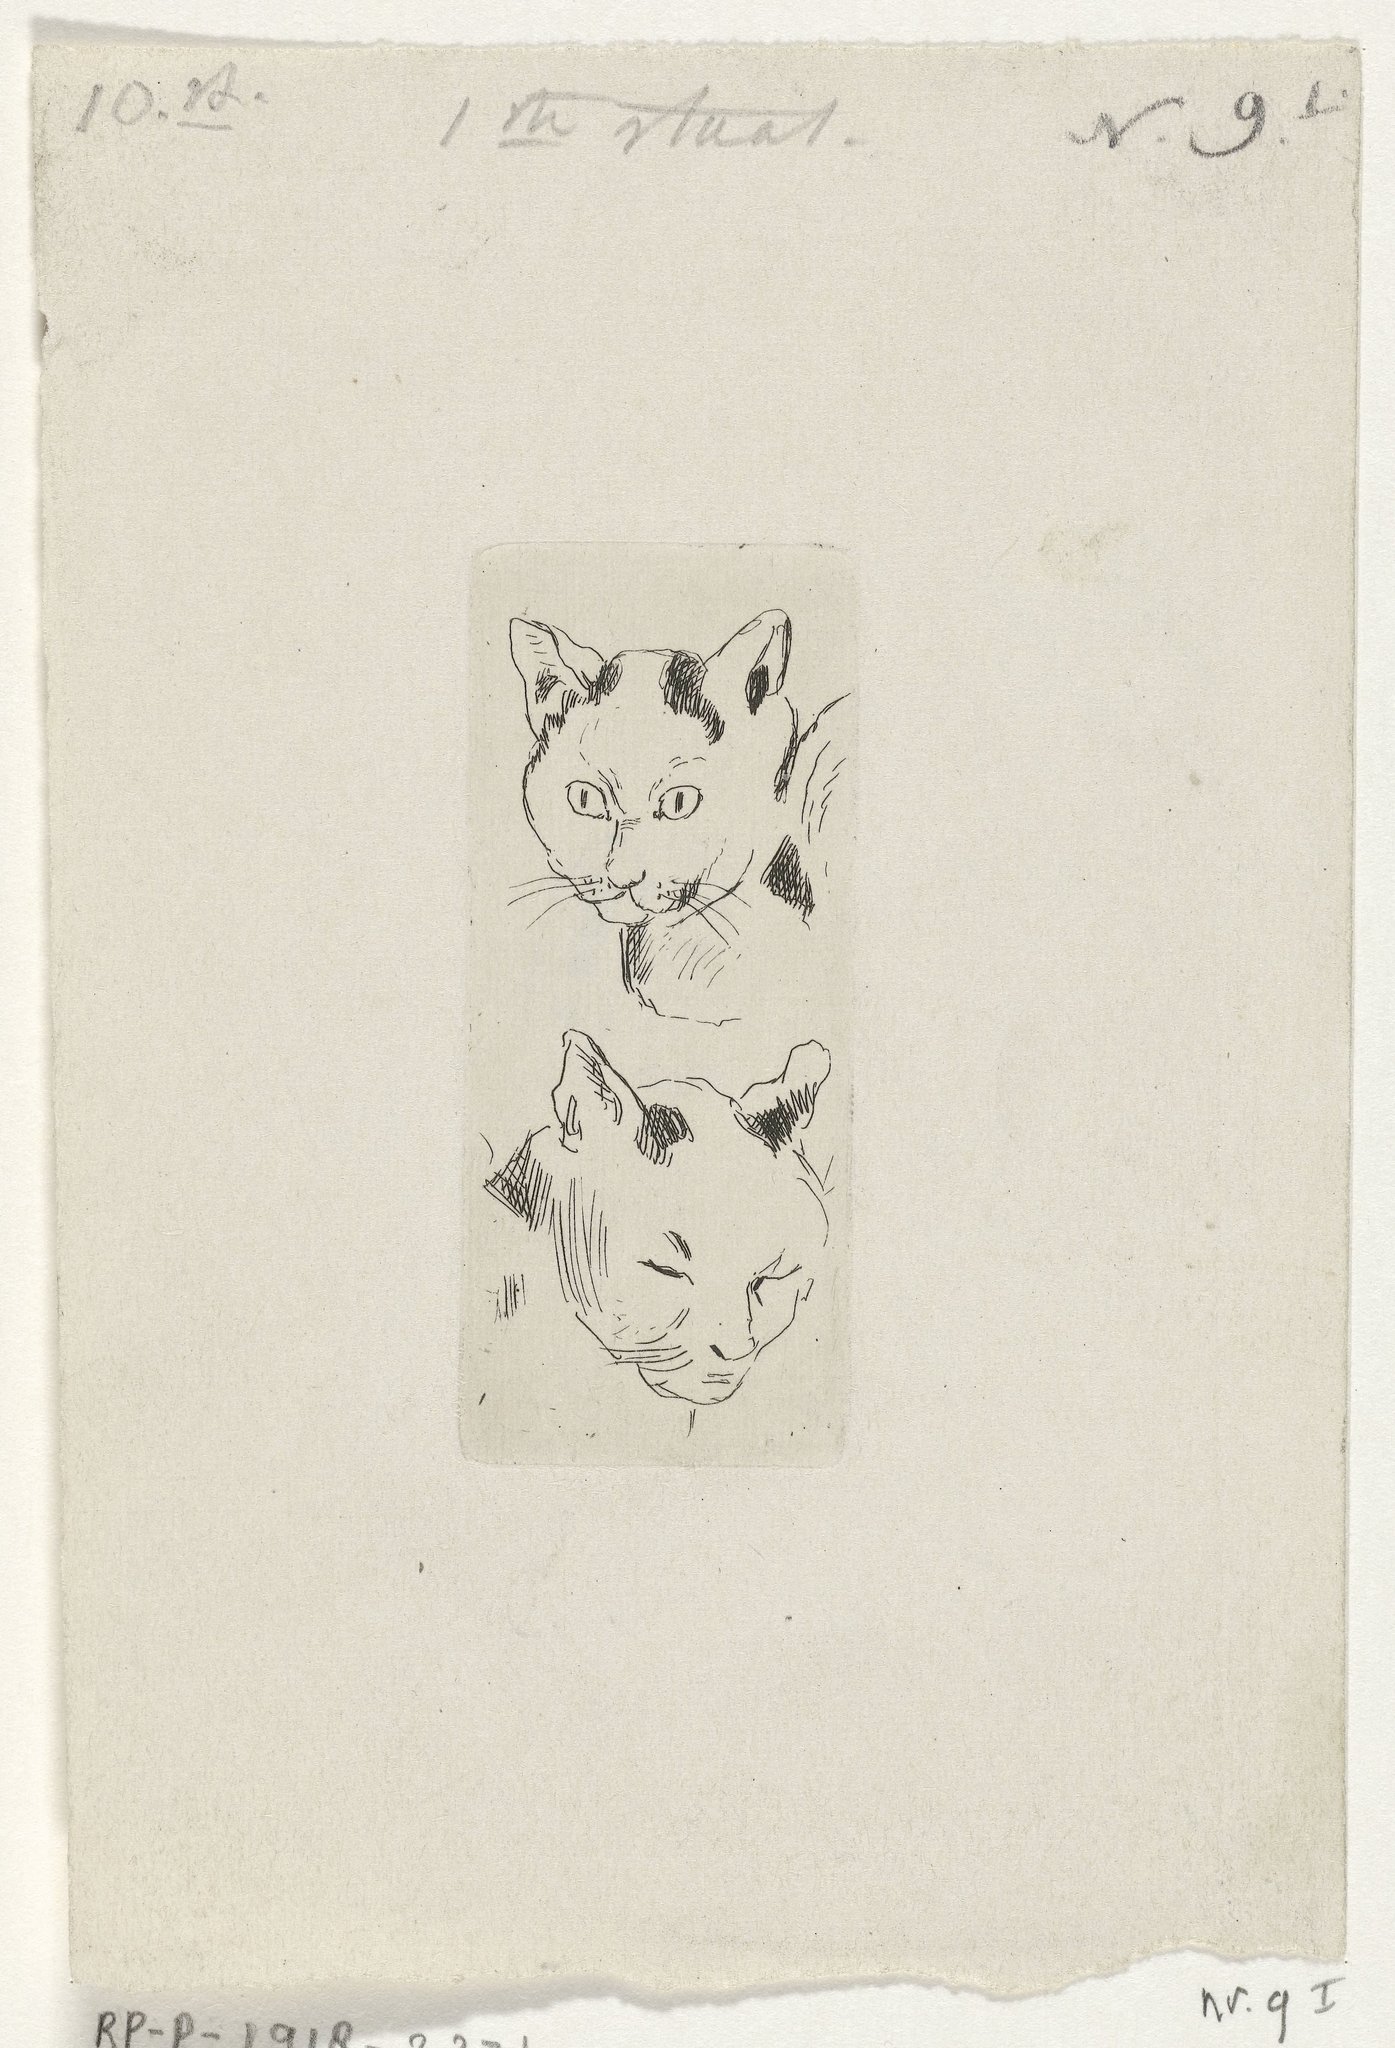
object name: print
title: Twee katten koppen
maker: cornelis van der griendt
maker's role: draughtsman, painter, print maker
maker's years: 1827-1918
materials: paper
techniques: etching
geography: netherlands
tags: cat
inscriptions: collector's mark: Lugt 2228